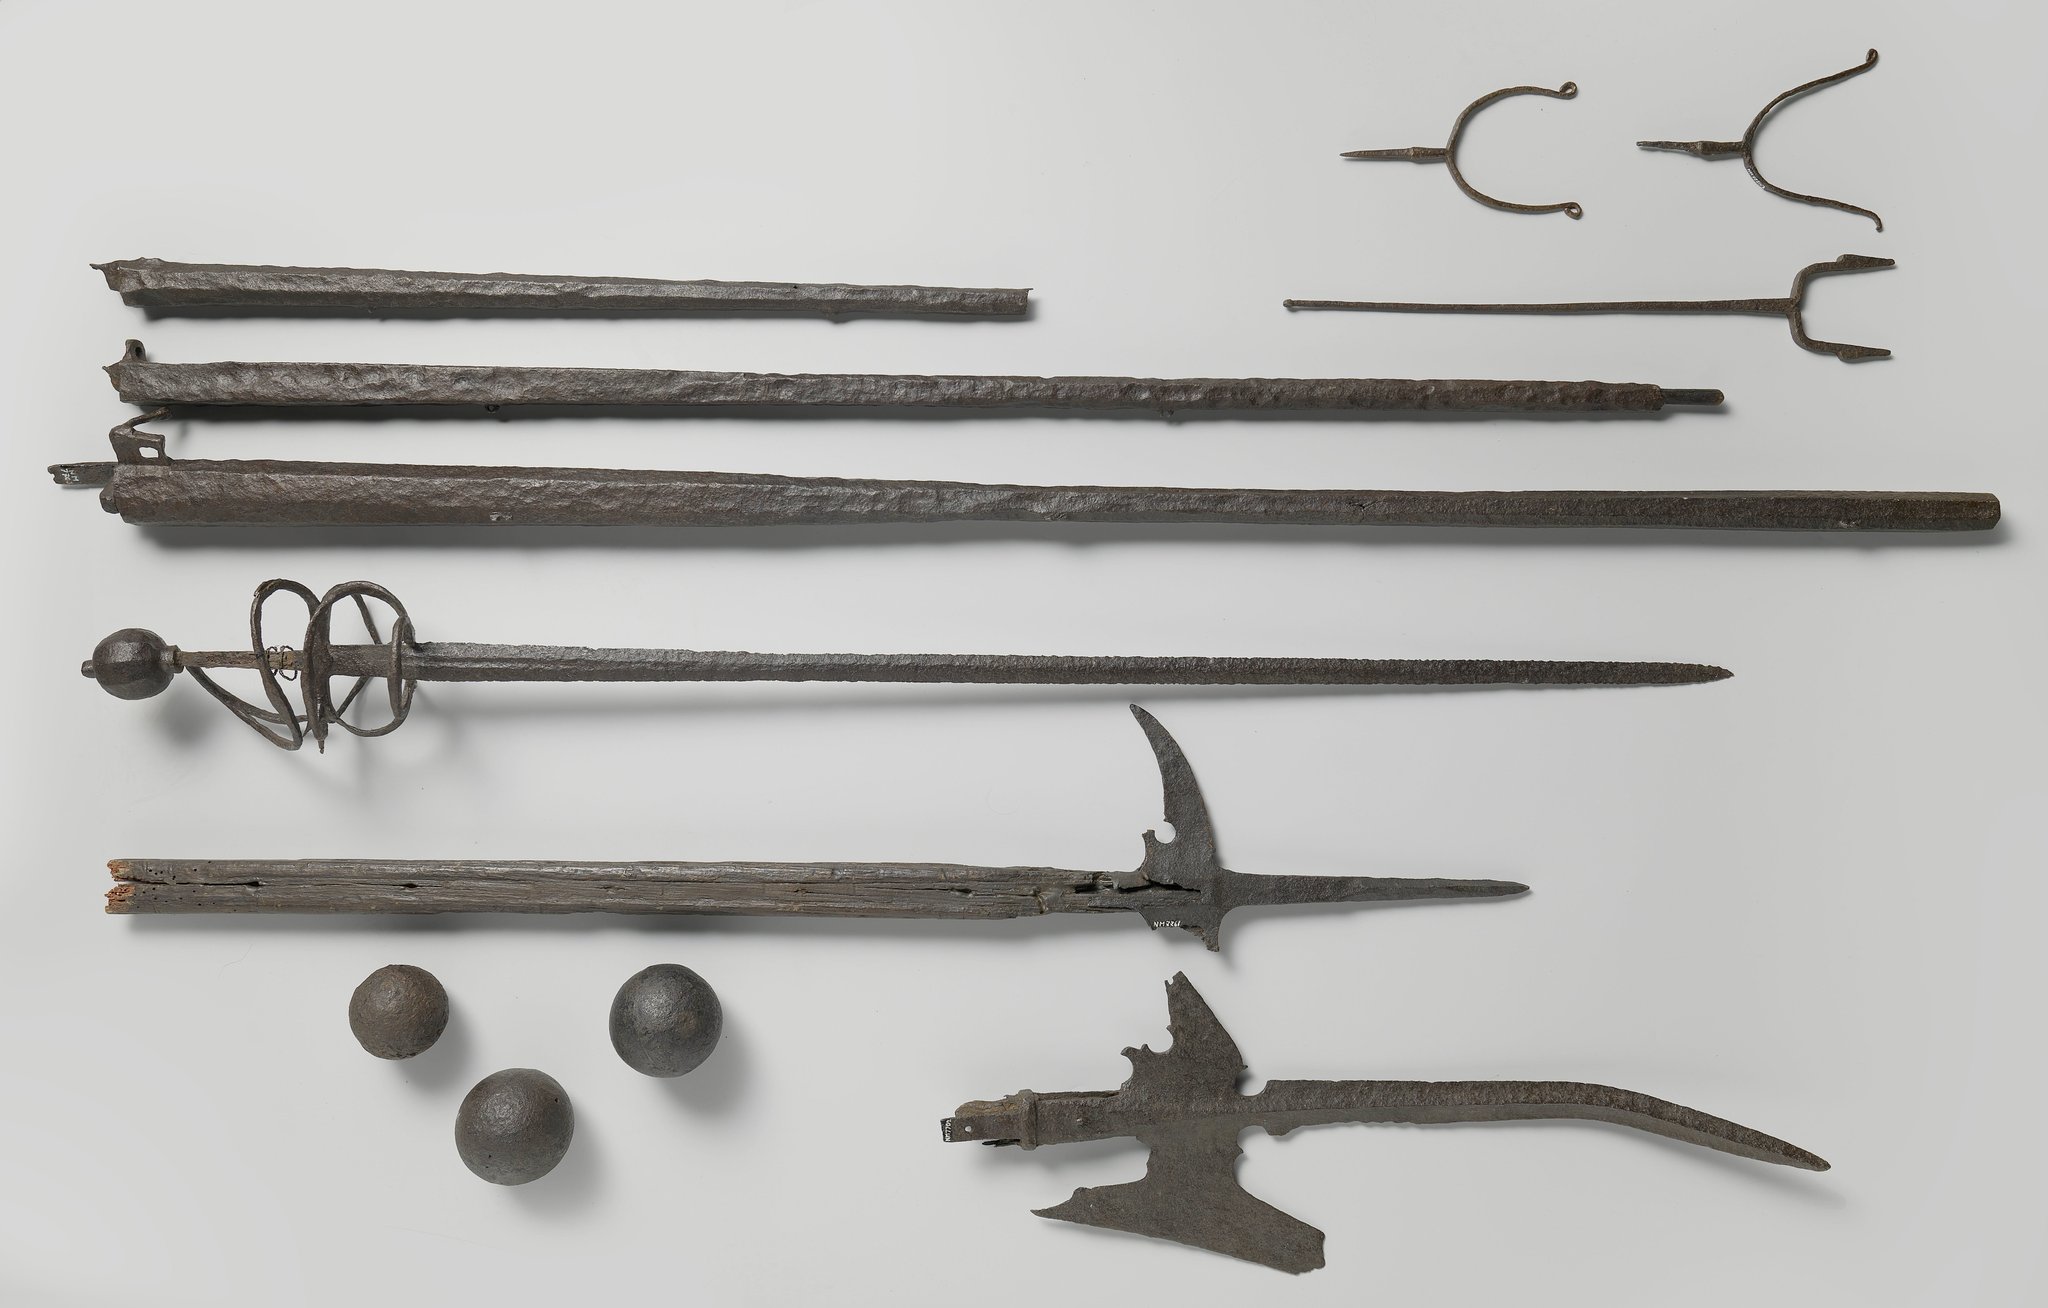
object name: bullet ammunition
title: Kanonskogel met nauwelijks zichtbare gietnaad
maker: Anonymous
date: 1590-1596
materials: iron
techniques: casting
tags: willem barendsz., amsterdam, jacob van heemskerck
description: 3-pound iron cannonballs